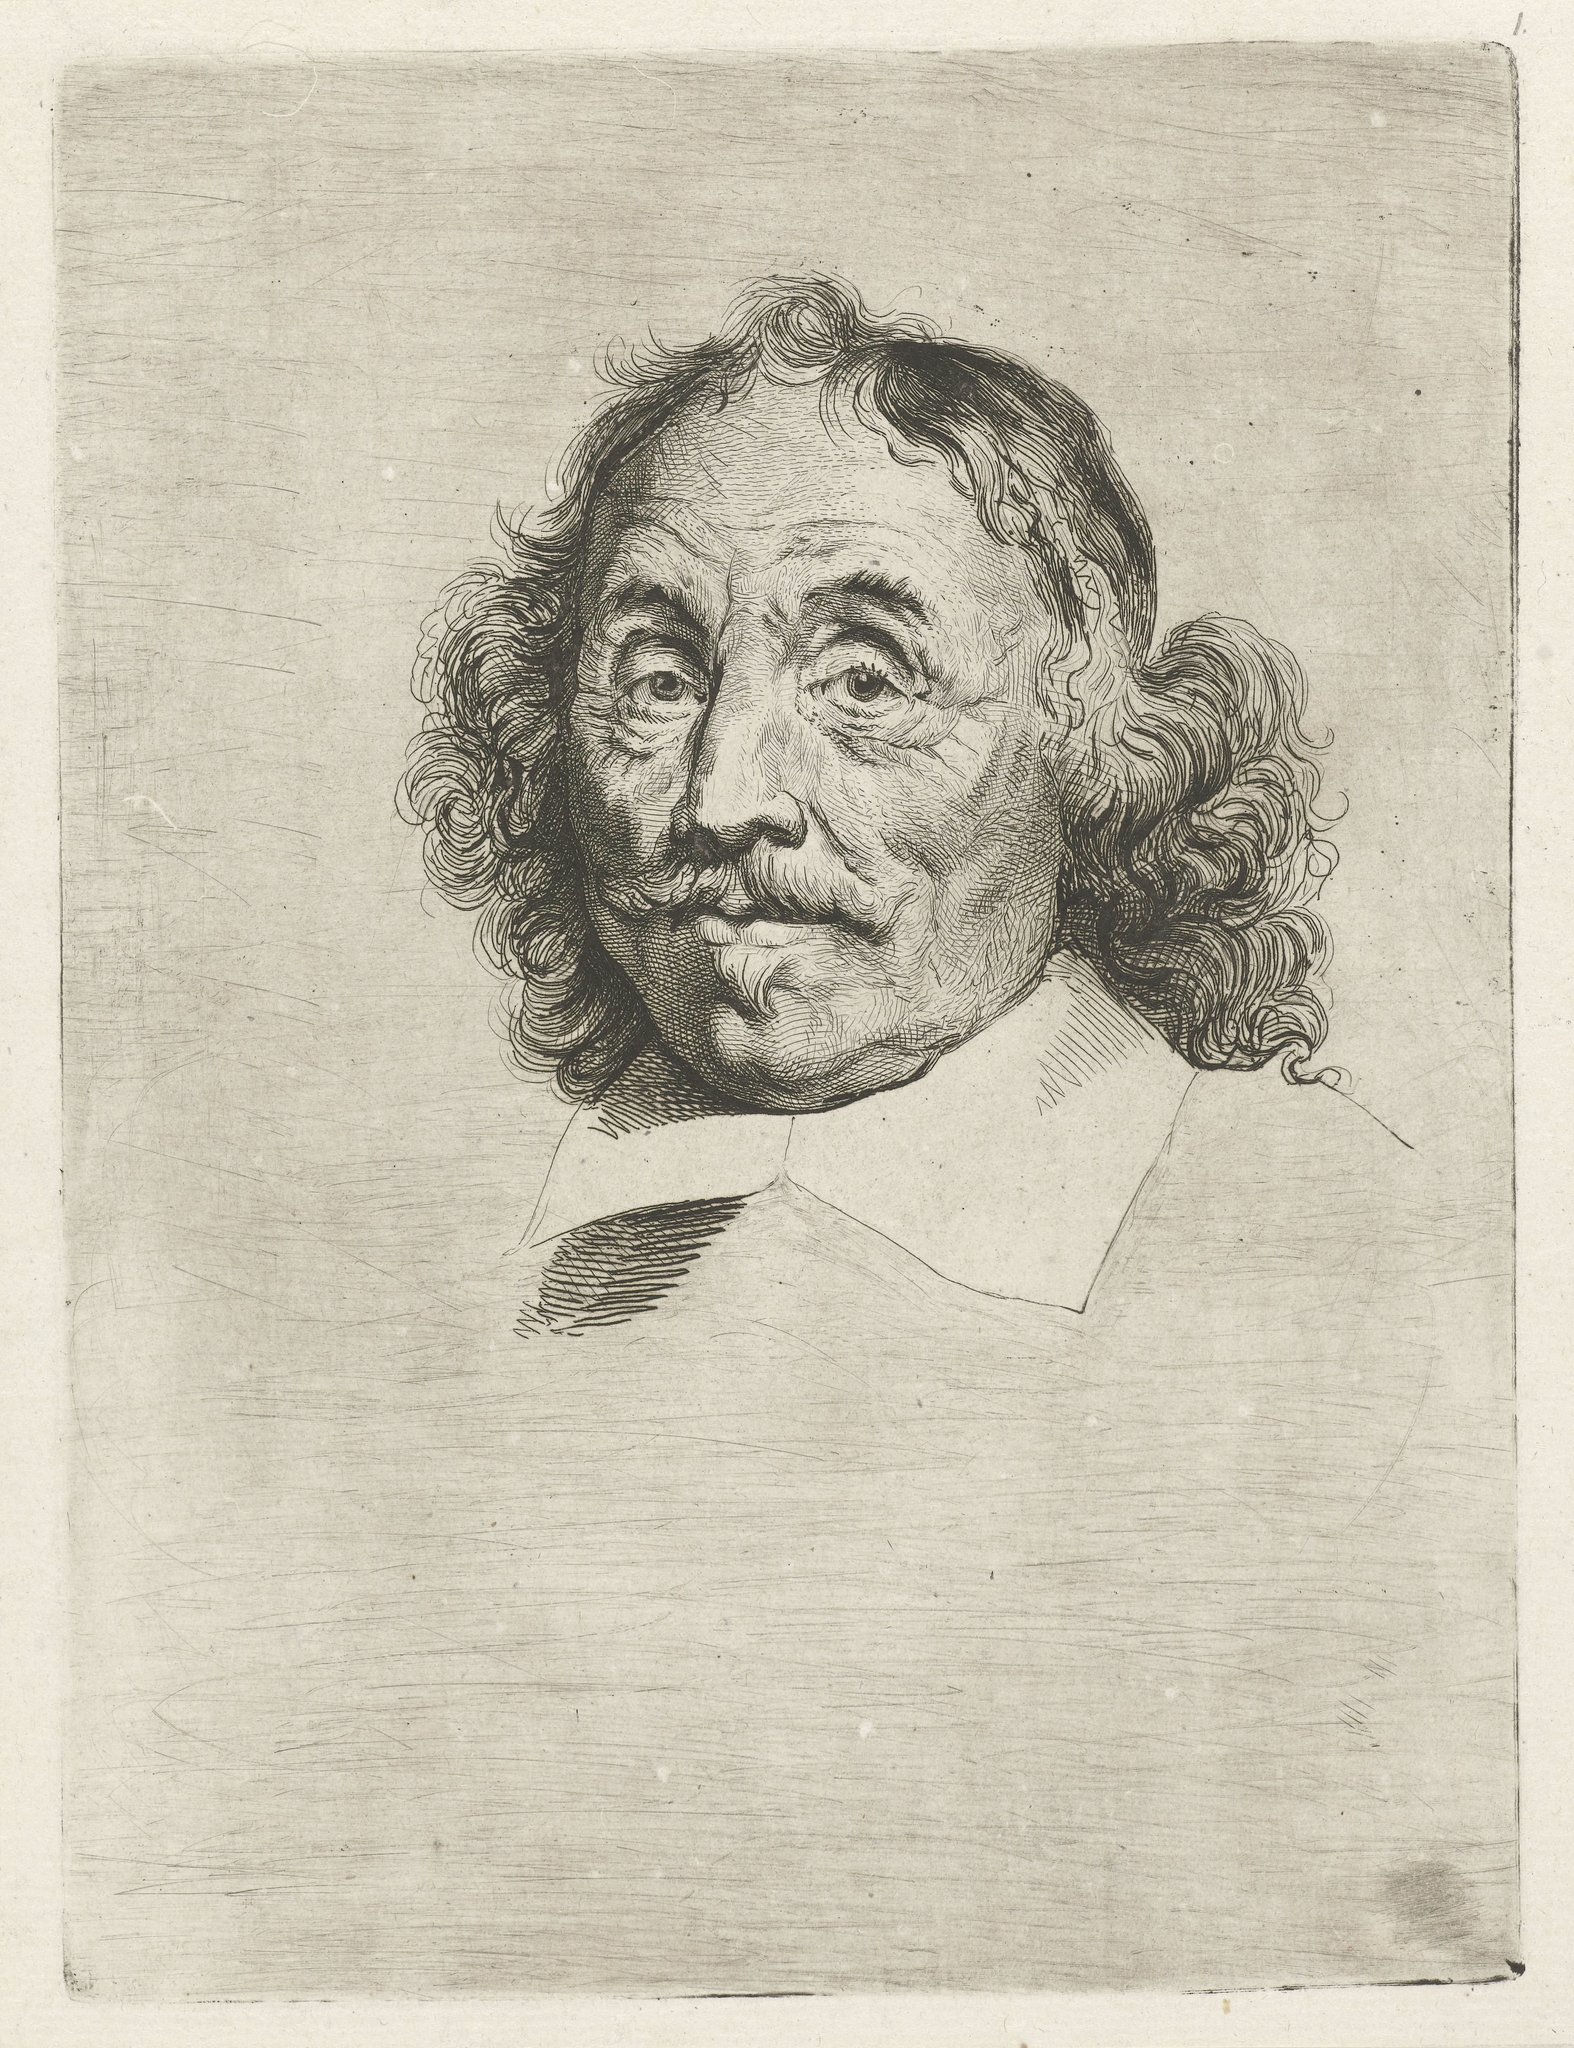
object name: print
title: Portret van Maarten Harpertszoon Tromp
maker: johannes pieter de frey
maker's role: draughtsman, print maker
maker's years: 1770-1834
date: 1801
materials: paper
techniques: etching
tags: brielle, maarten harpertszoon tromp, historical persons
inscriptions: collector's mark: Lugt 12, number: ‘1’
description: Portret van admiraal Maarten Harpertszoon Tromp waarbij alleen het hoofd in detail is uitgewerkt. Portretbuste en face, iets naar links.